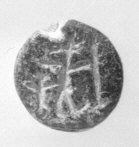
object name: stamp seal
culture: iranian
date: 1000-1 BCE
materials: stone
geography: iran